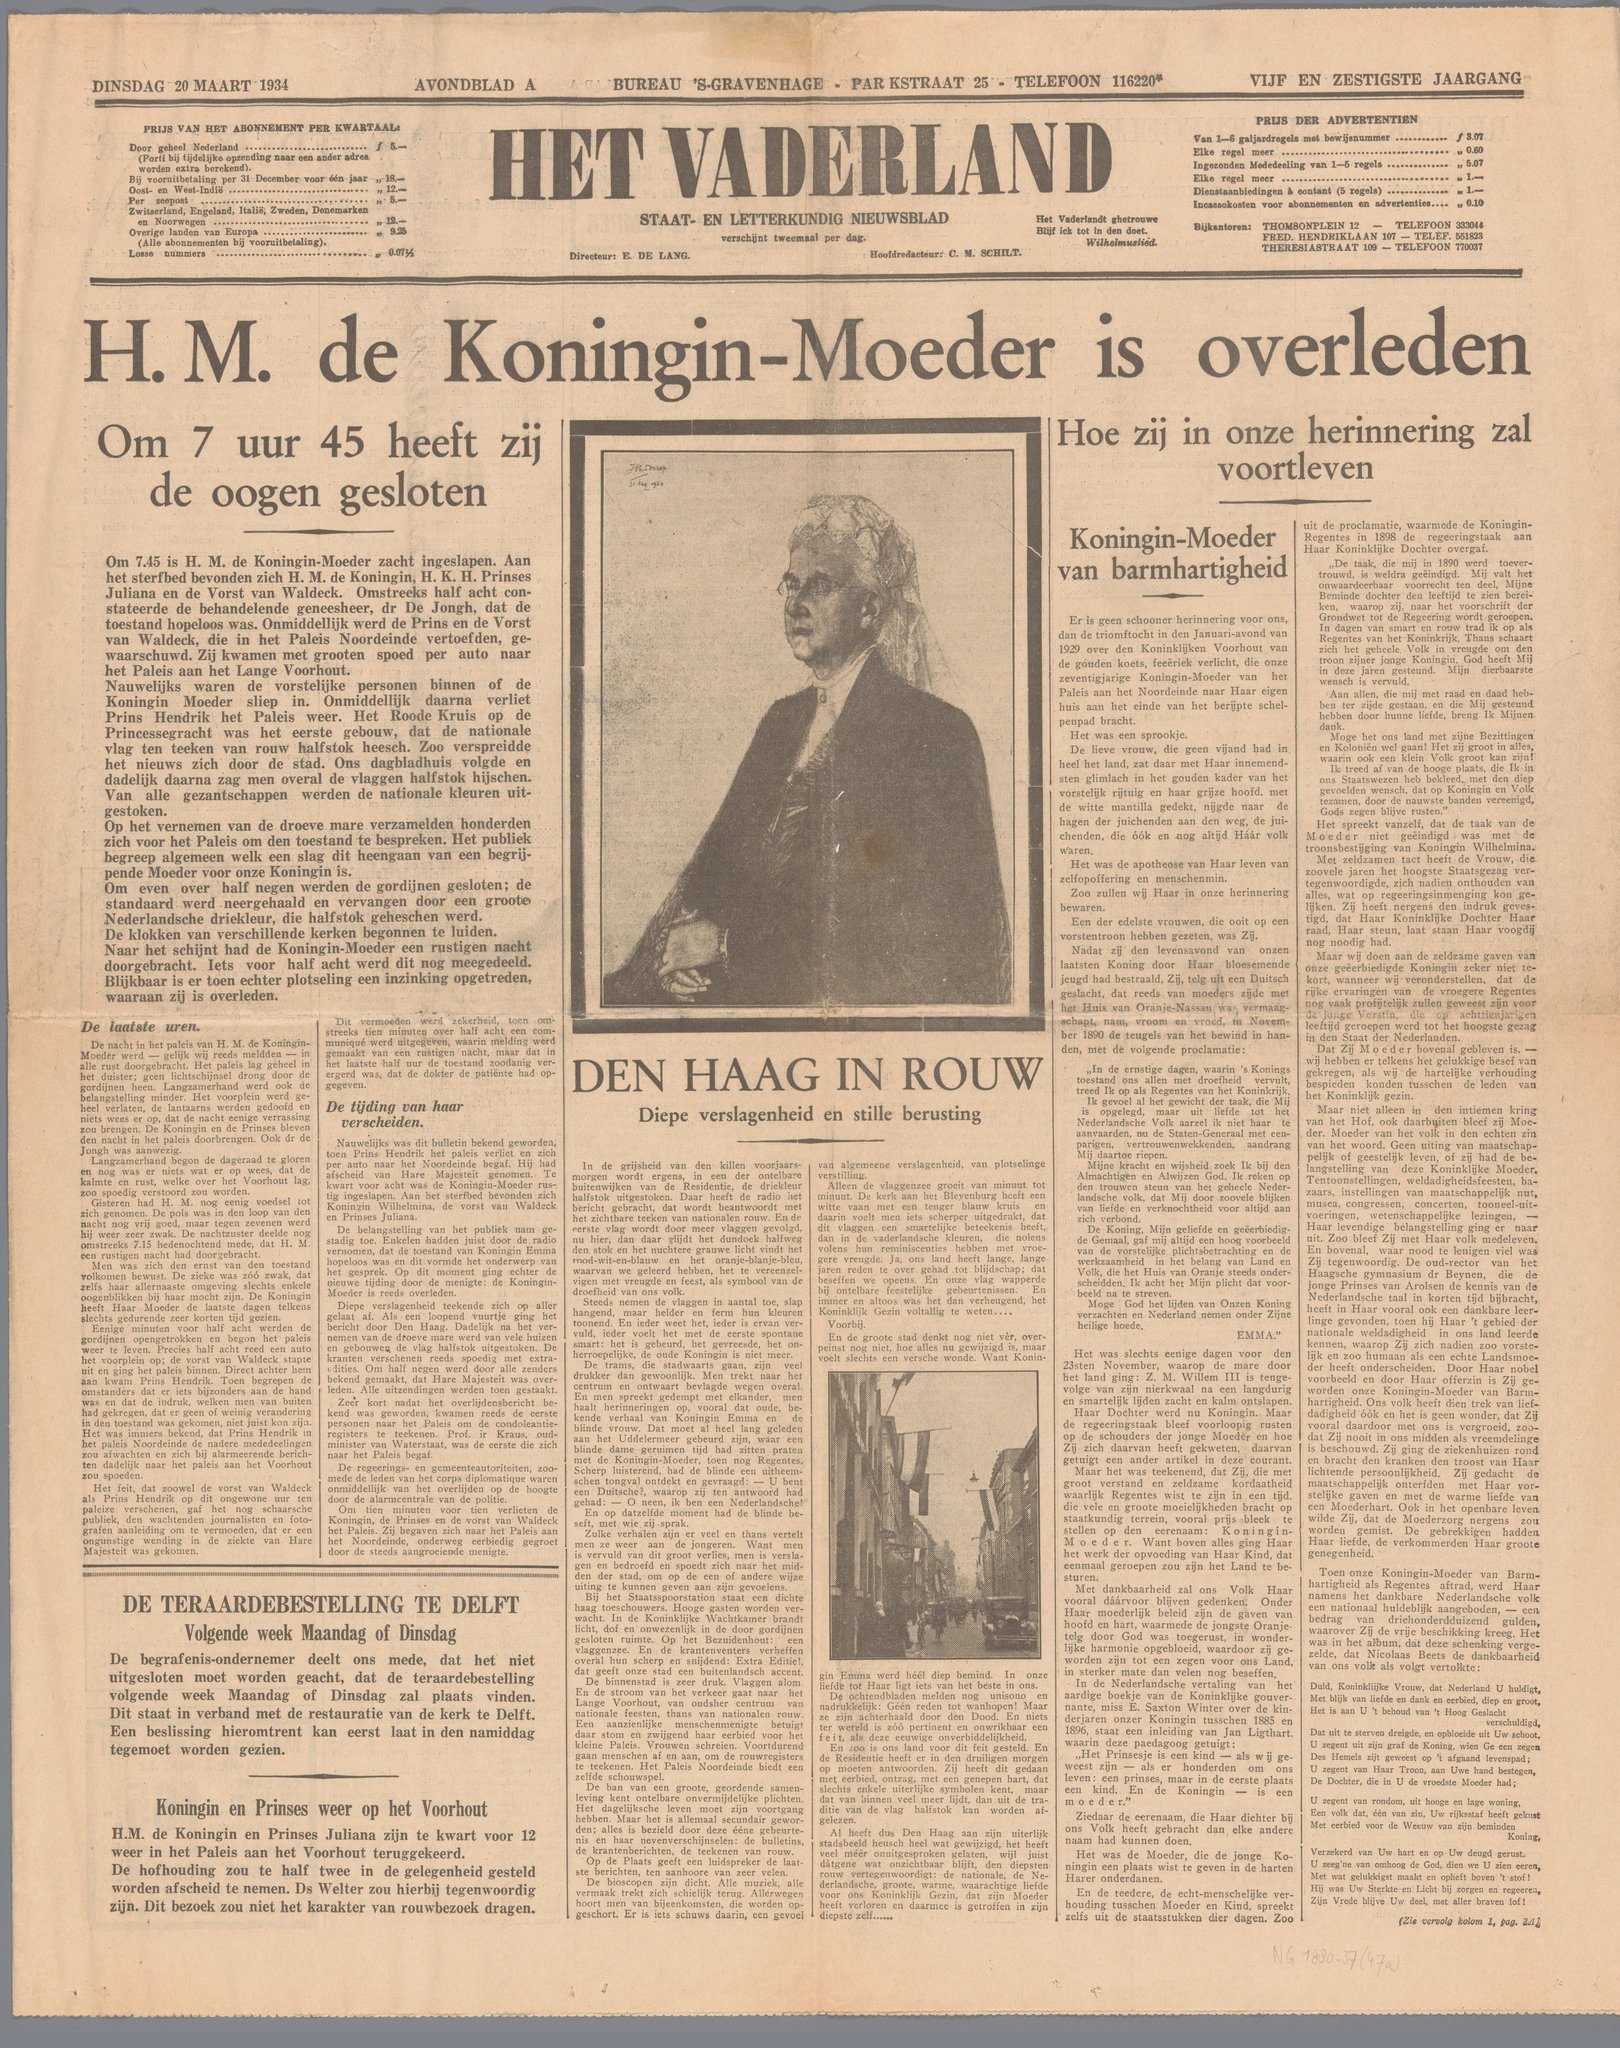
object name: newspaper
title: Het Vaderland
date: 1934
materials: paper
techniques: printing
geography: the hague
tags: the hague, emma (queen consort of the netherlands), netherlands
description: Krant, 65e jaargang van "Het Vaderland", 4pp, over dood van Emma, voorpagina portret Emma in zwart kader.